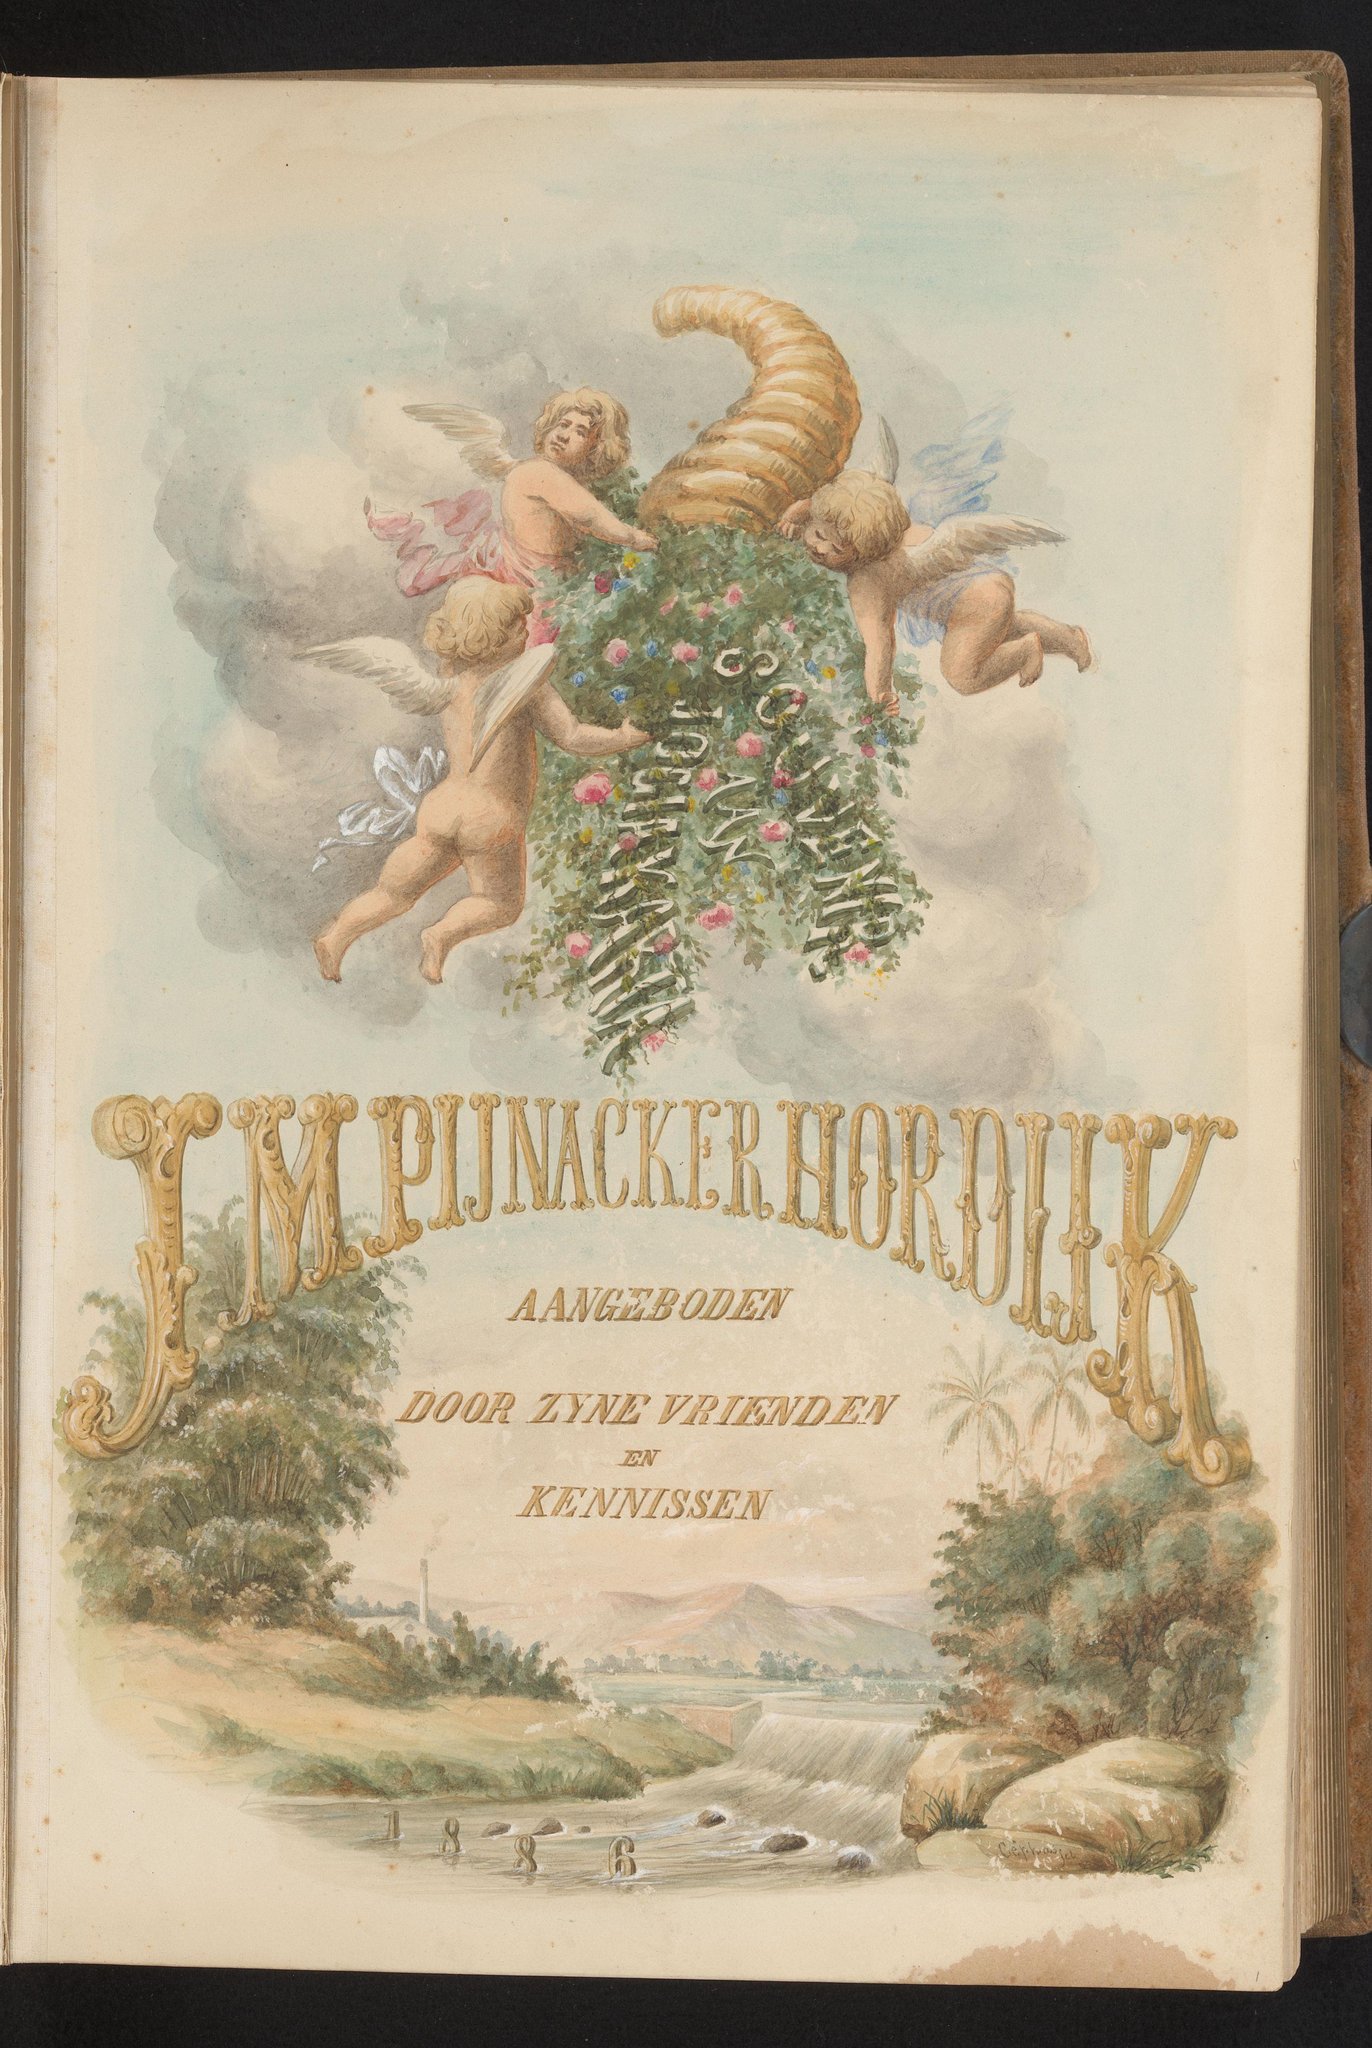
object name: drawing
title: Getekend titelblad van het fotoalbum aangeboden aan J.M. Pijnacker Hordijk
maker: kassian céphas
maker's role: fotograaf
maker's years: 1845-1912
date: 1886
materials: paper, watercolor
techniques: drawing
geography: jogjakarta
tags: the hague, colonial system, plantation, 'cornucopia', horn of plenty, factory-building, factory in landscape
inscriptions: signature: ‘Céphas fct’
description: Getekend titelblad met opdracht aan J.M. Pijnacker Hordijk. Bovenaan drie engelen met een hoorn van overvloed, onderaan een Indonesisch landschap met cultuurvelden en een fabriek en met de cijfers van de datum 1886 staande in een riviertje. Onderdeel van het fotoalbum aangeboden aan J.M. Pijnacker Hordijk bij zijn vertrek uit Jogjakarta in 1886.